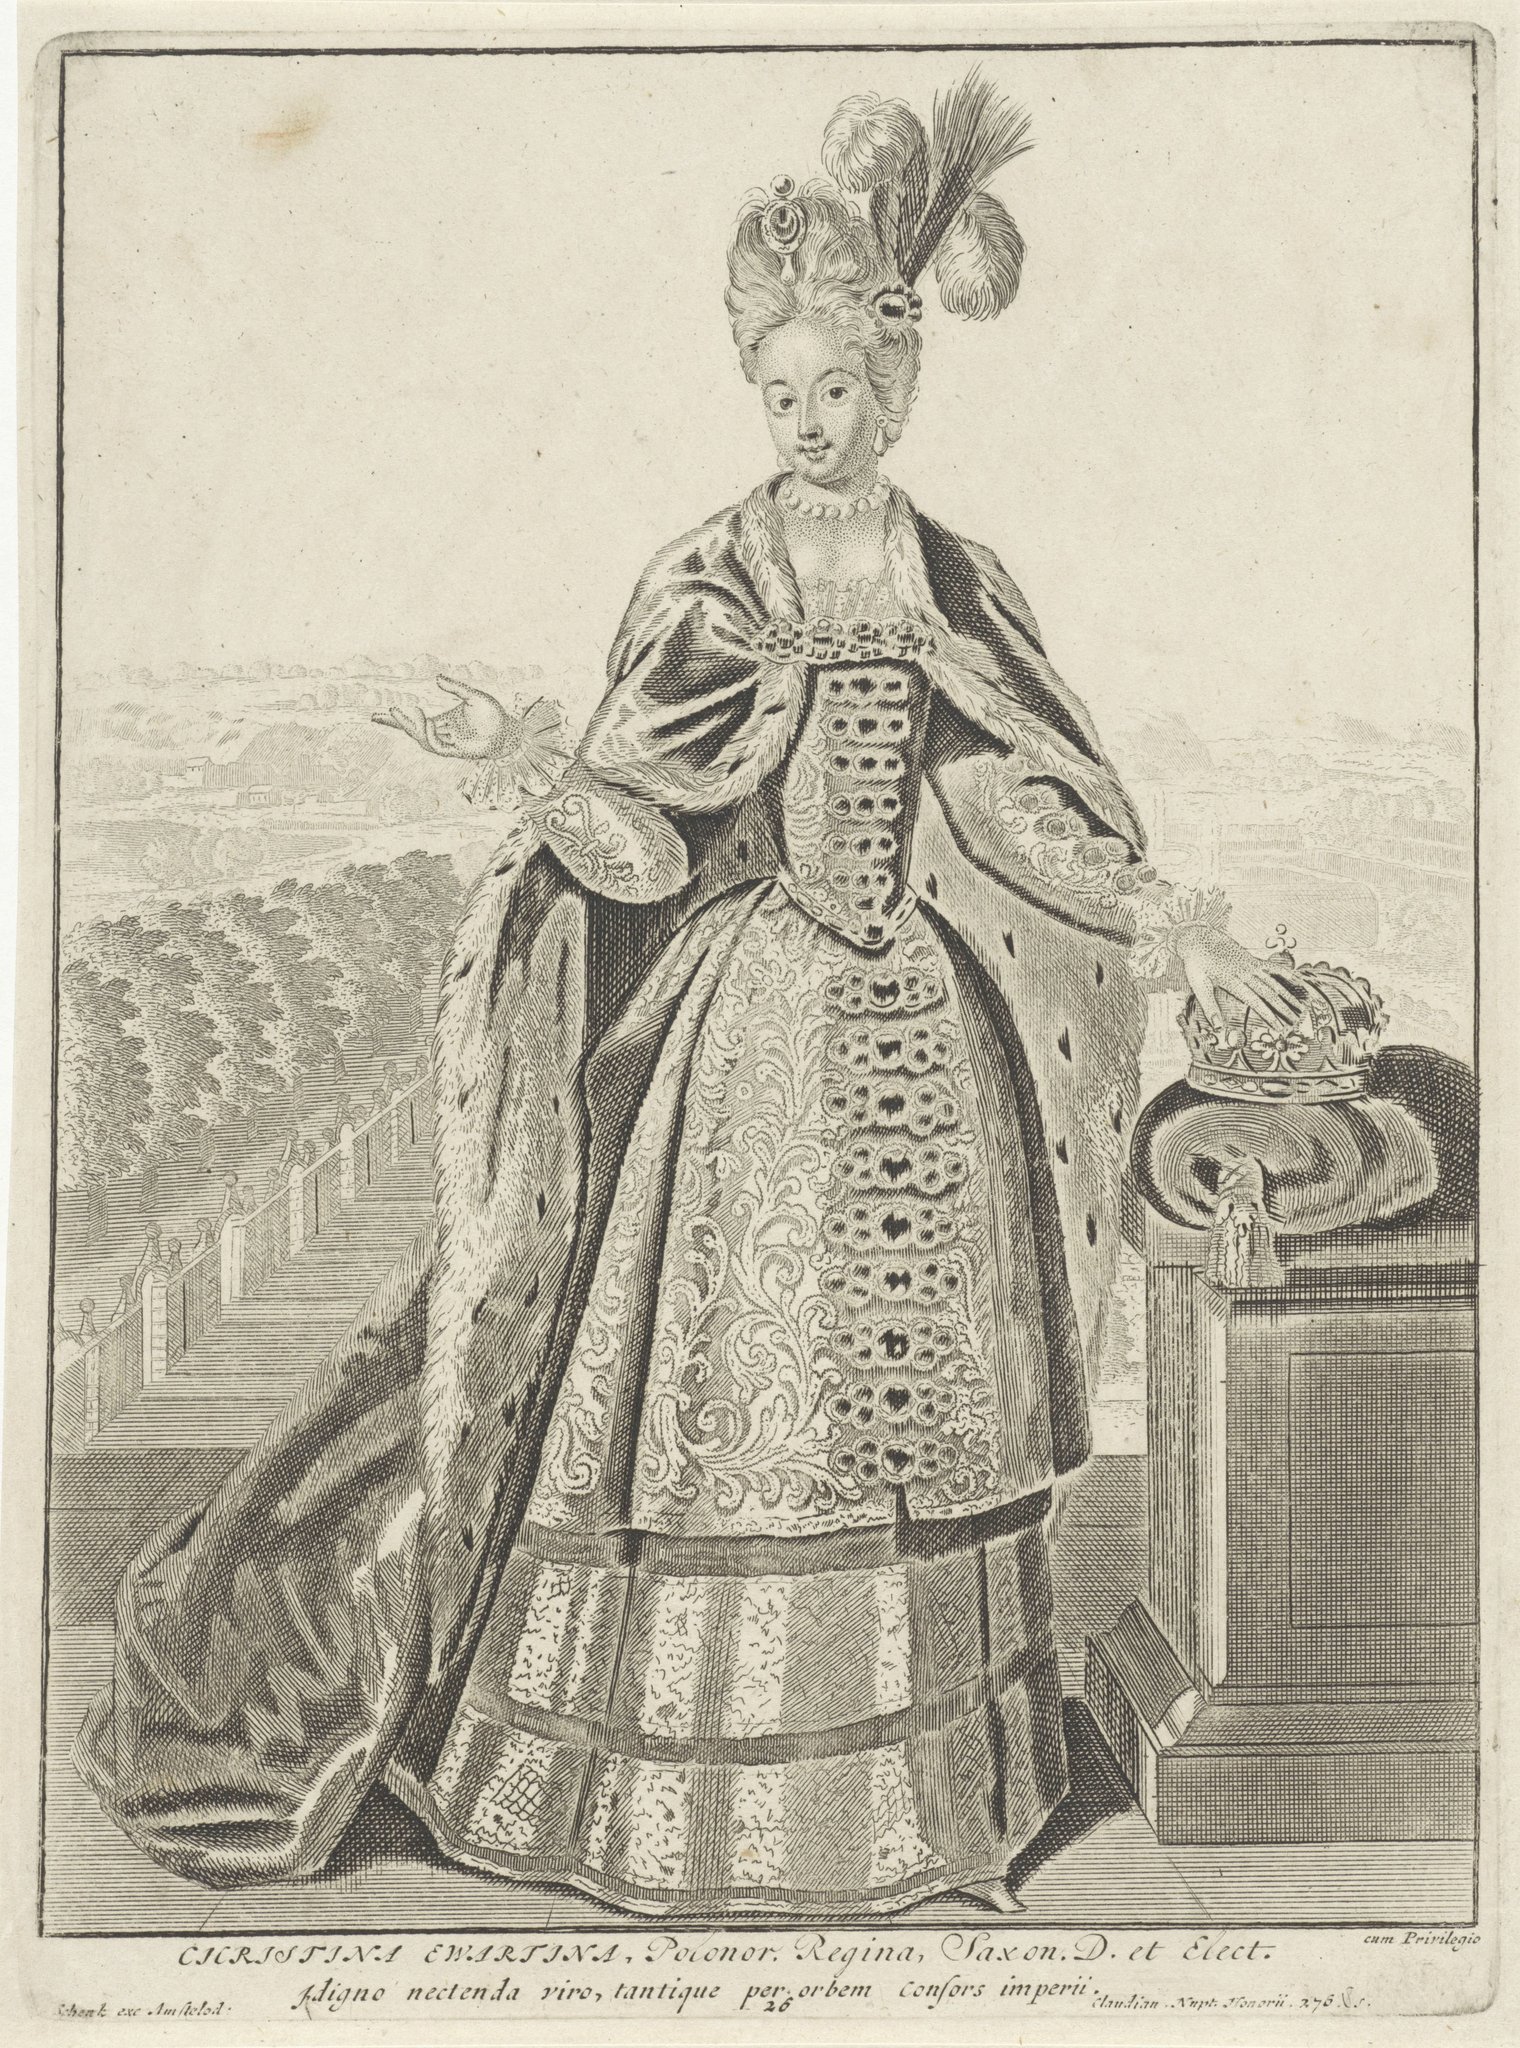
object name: costume print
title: Portret van Christina Ewartina van Saksen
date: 1675-1711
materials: paper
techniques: engraving, etching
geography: amsterdam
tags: crown (symbol of sovereignty), garden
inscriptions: collector's mark: Lugt 2228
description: Christina Ewartina, hertogin van Saksen met veren in het haar. Naast haar de kroon.